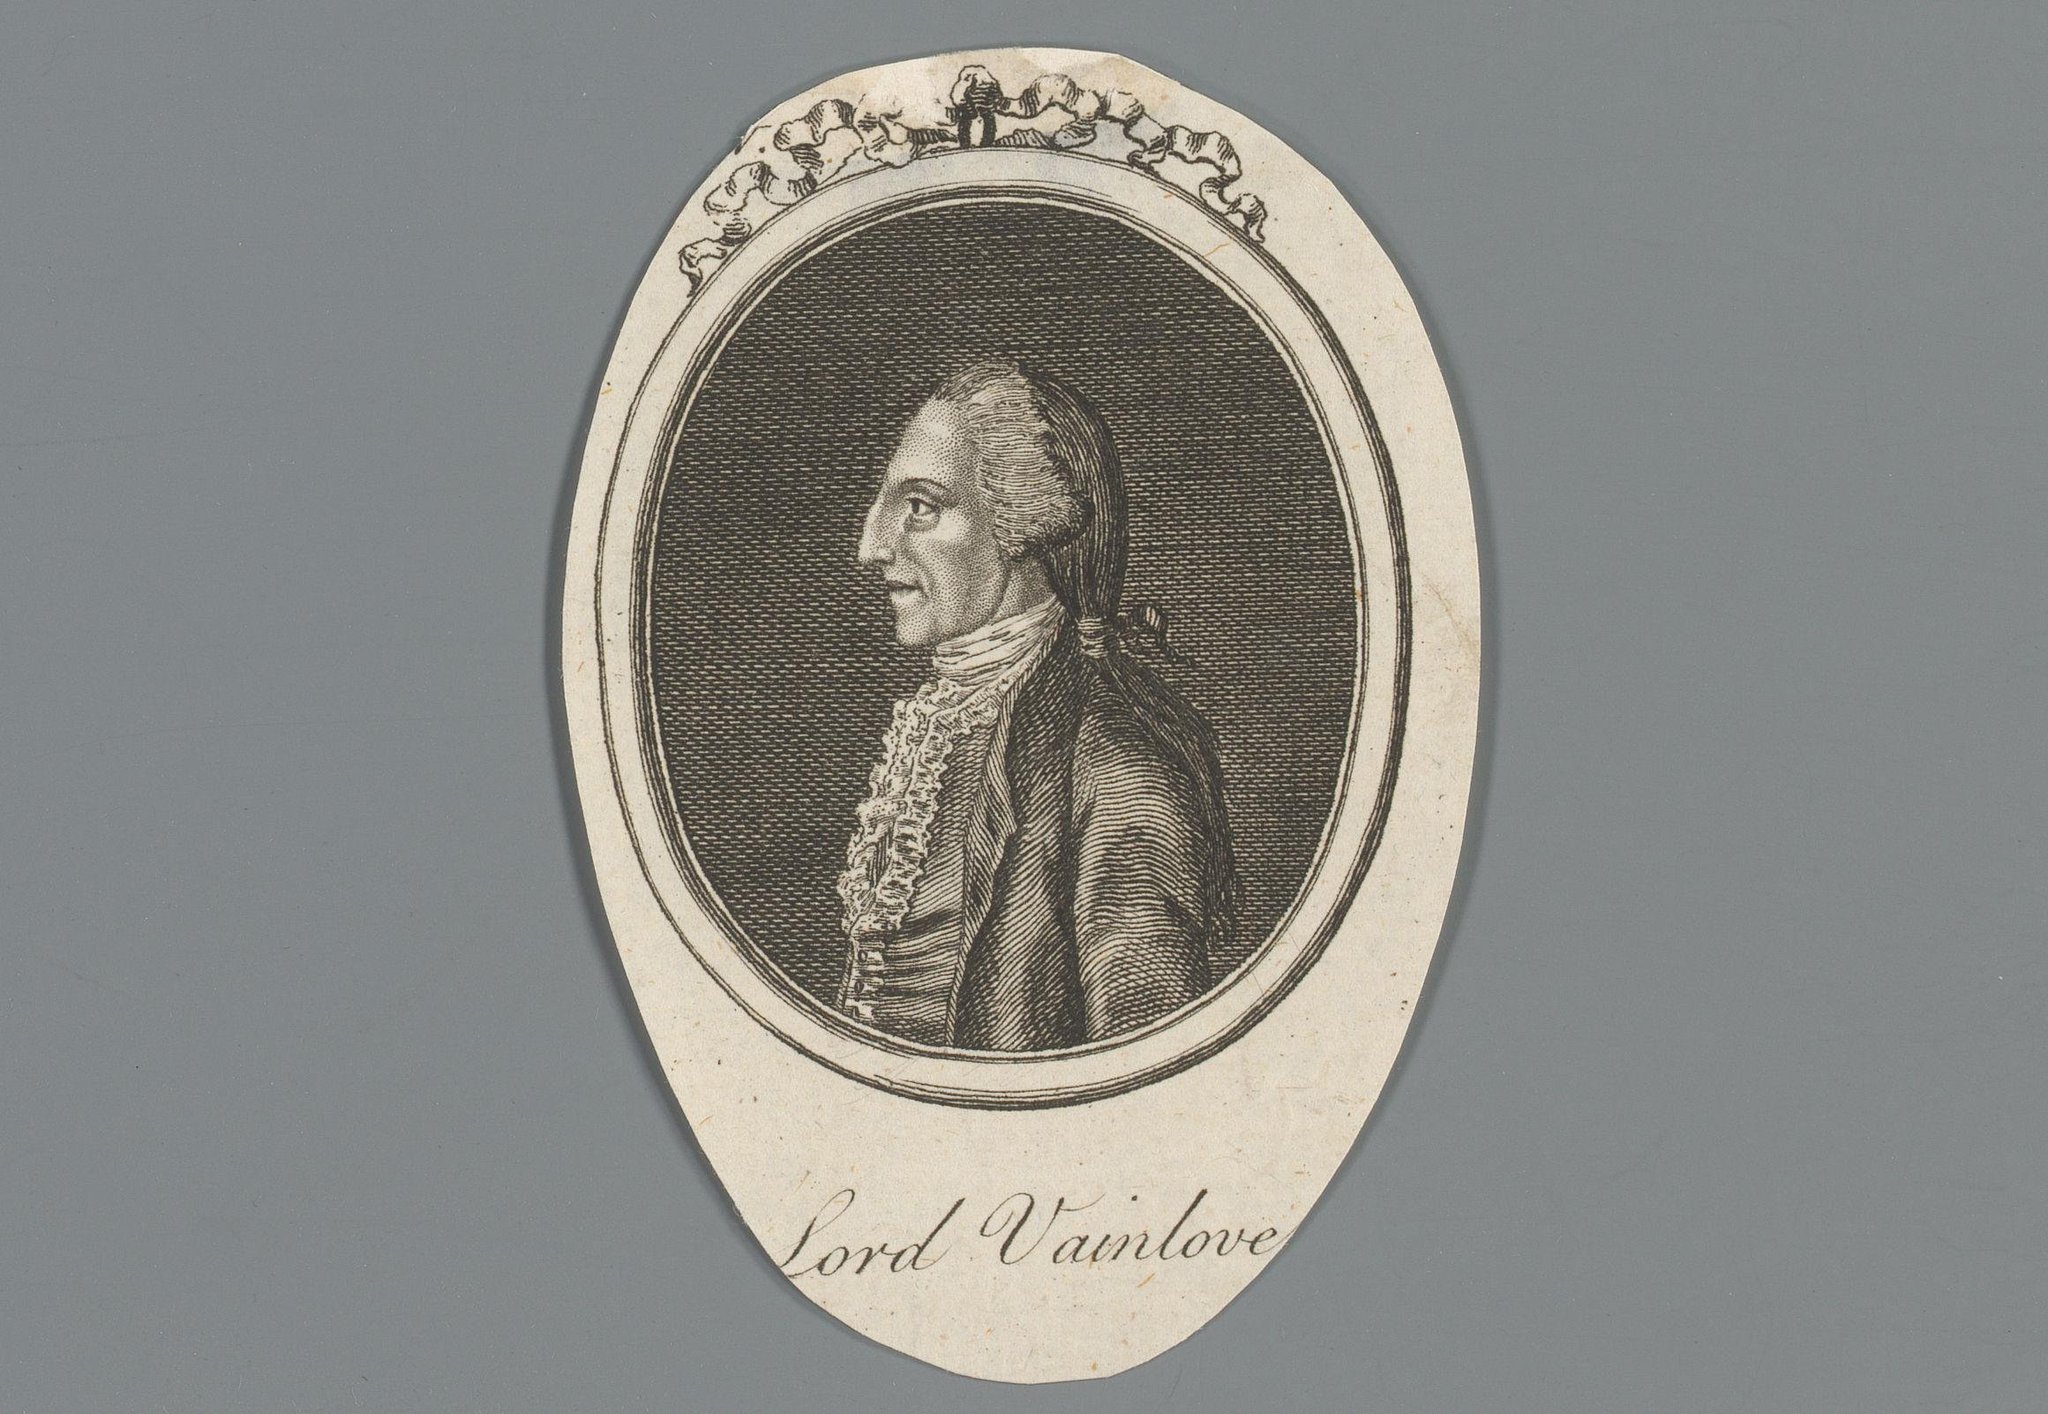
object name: print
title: Portret van William Vane als "Lord Vainlove"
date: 1771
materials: paper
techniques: etching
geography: london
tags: historical persons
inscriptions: collector's mark: Lugt 2228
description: Prent waarschijnlijk uit: Town and Country Magazine 3 (1771), februari 1771.